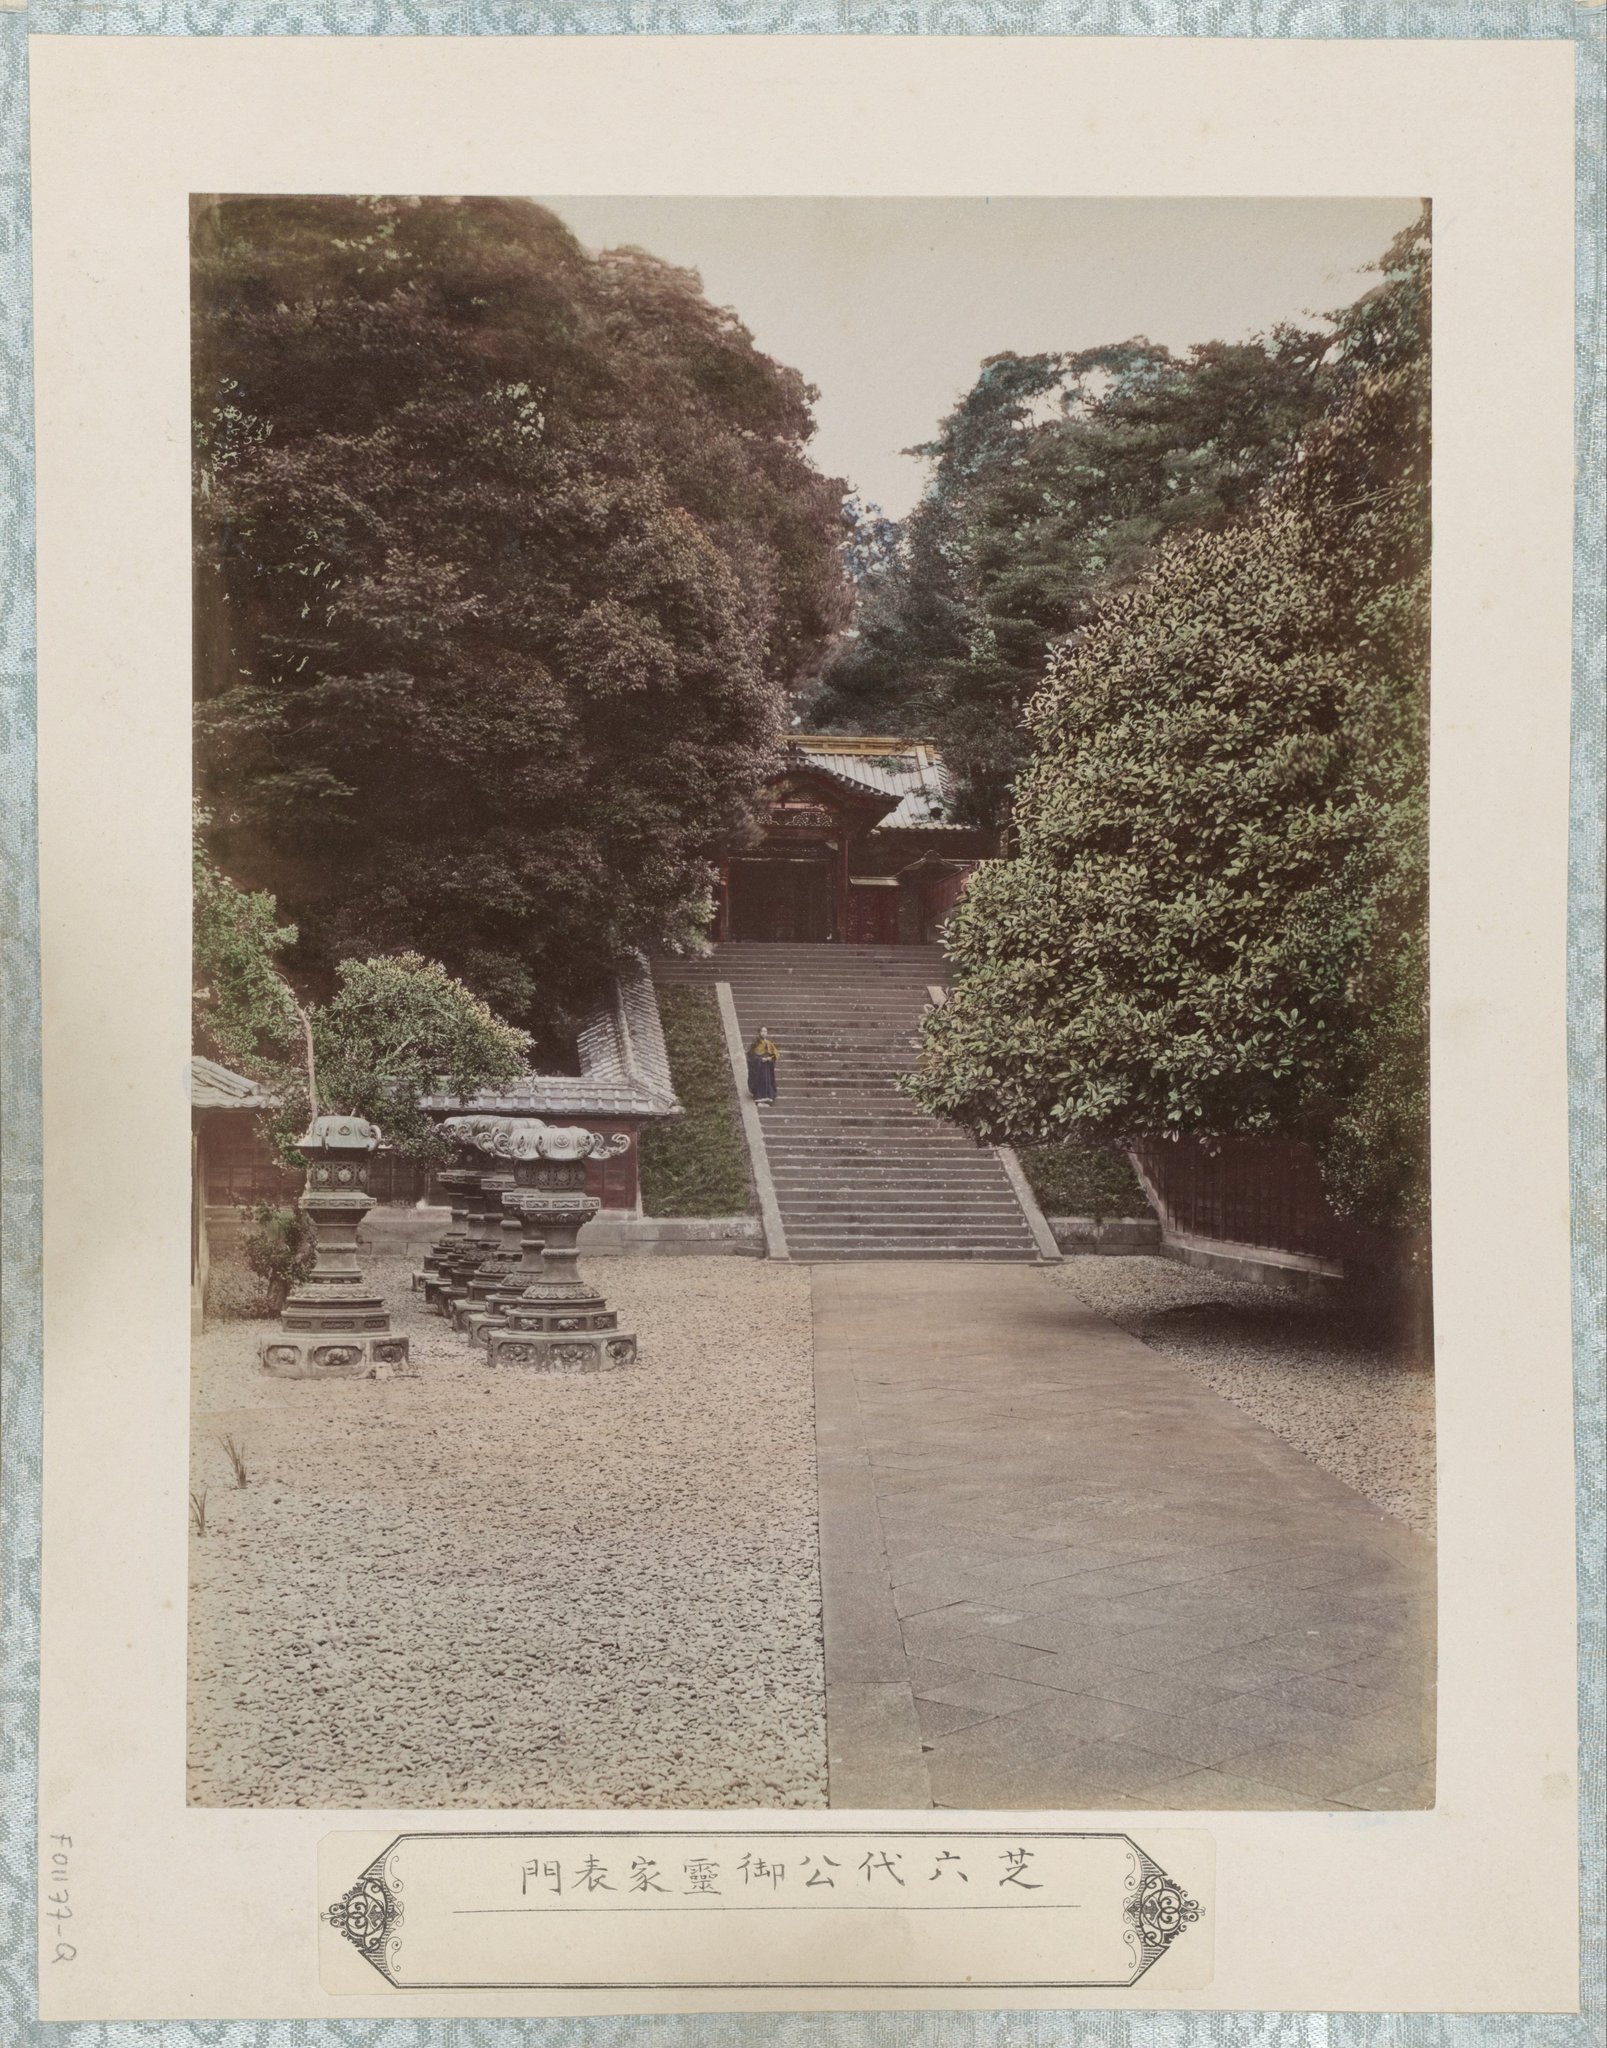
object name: photograph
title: Shiba rokudaikô mitamaya omotemon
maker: Anonymous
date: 1870-1900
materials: cardboard, paper, photographic support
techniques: albumen print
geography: tokyo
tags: temple, shrine ~ hinduism, buddhism, jainism, mausoleum, travelling; tourism, front steps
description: Onderdeel van Leporelloalbum met 30 foto's van bezienswaardigheden in Japan.